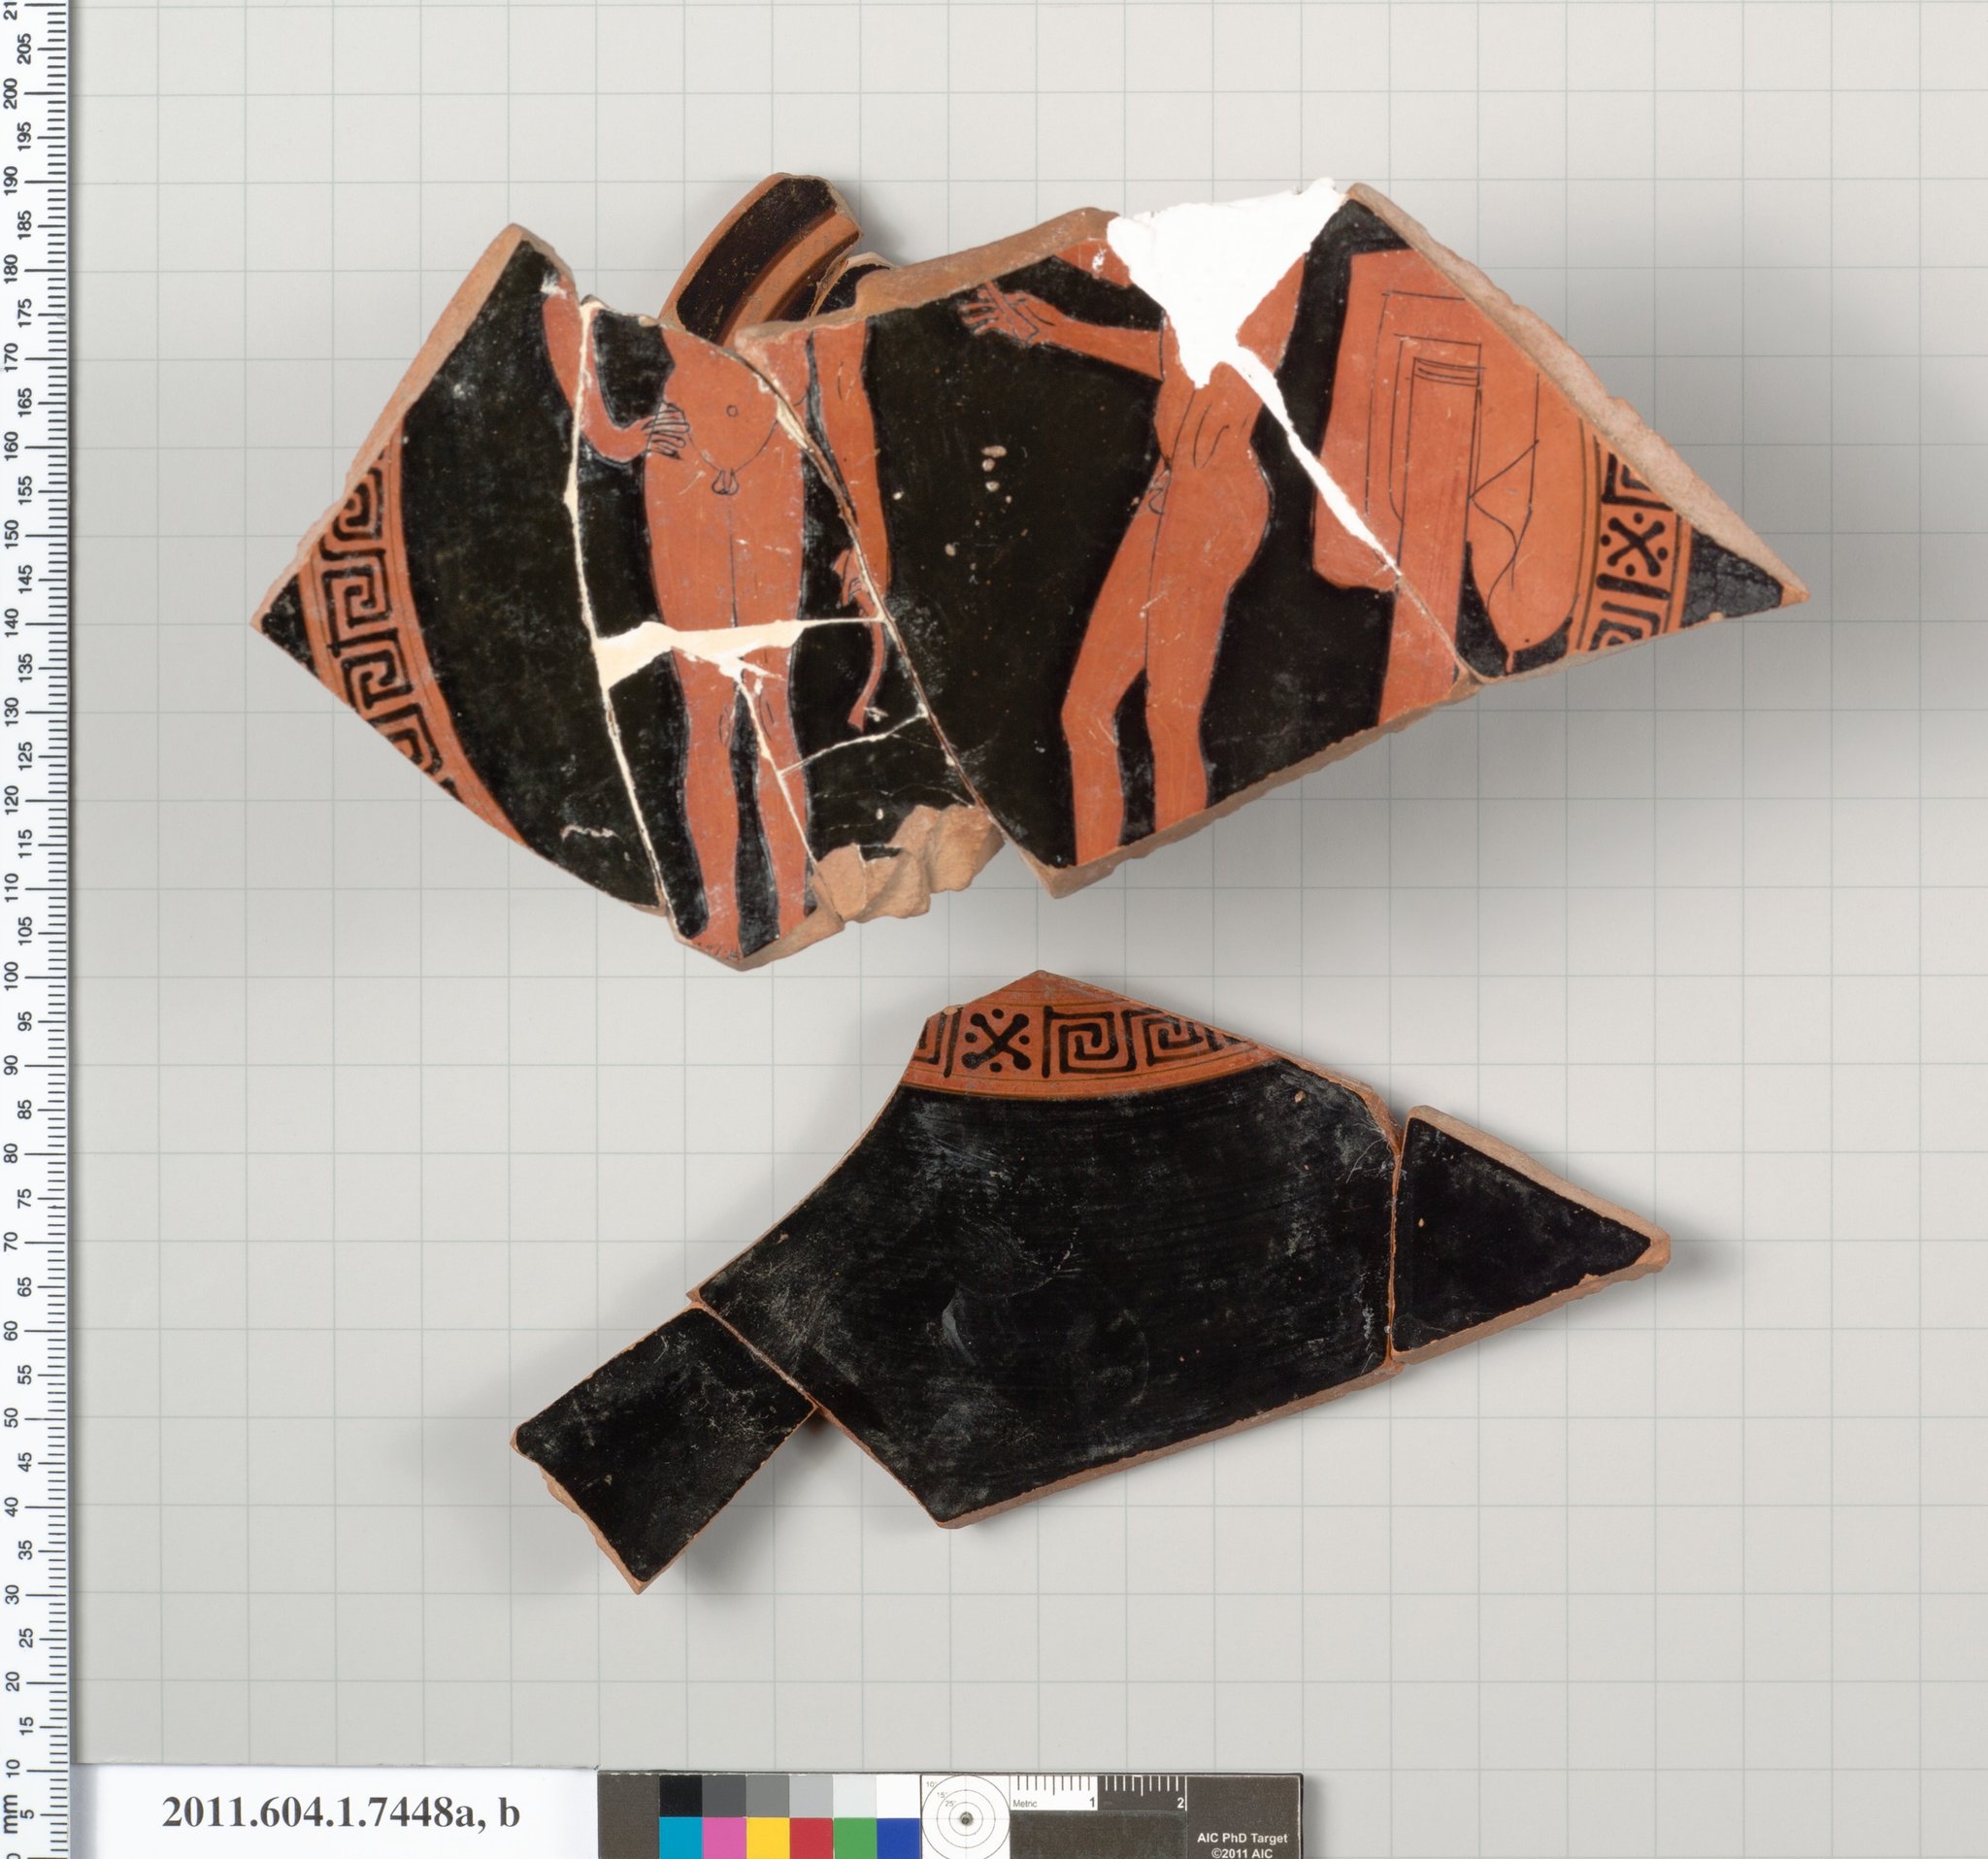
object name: kylix fragment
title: Terracotta fragments of a kylix (drinking cup)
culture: greek, attic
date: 490-470 BCE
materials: terracotta